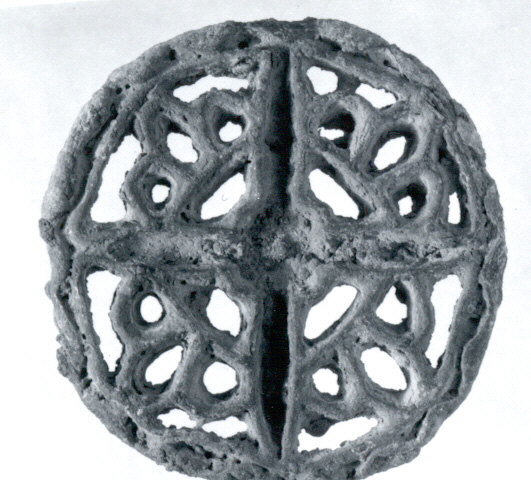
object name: stamp seal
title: Compartmented stamp seal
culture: bactria-margiana archaeological complex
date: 2333-1668 BCE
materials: copper alloy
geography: bactria-margiana